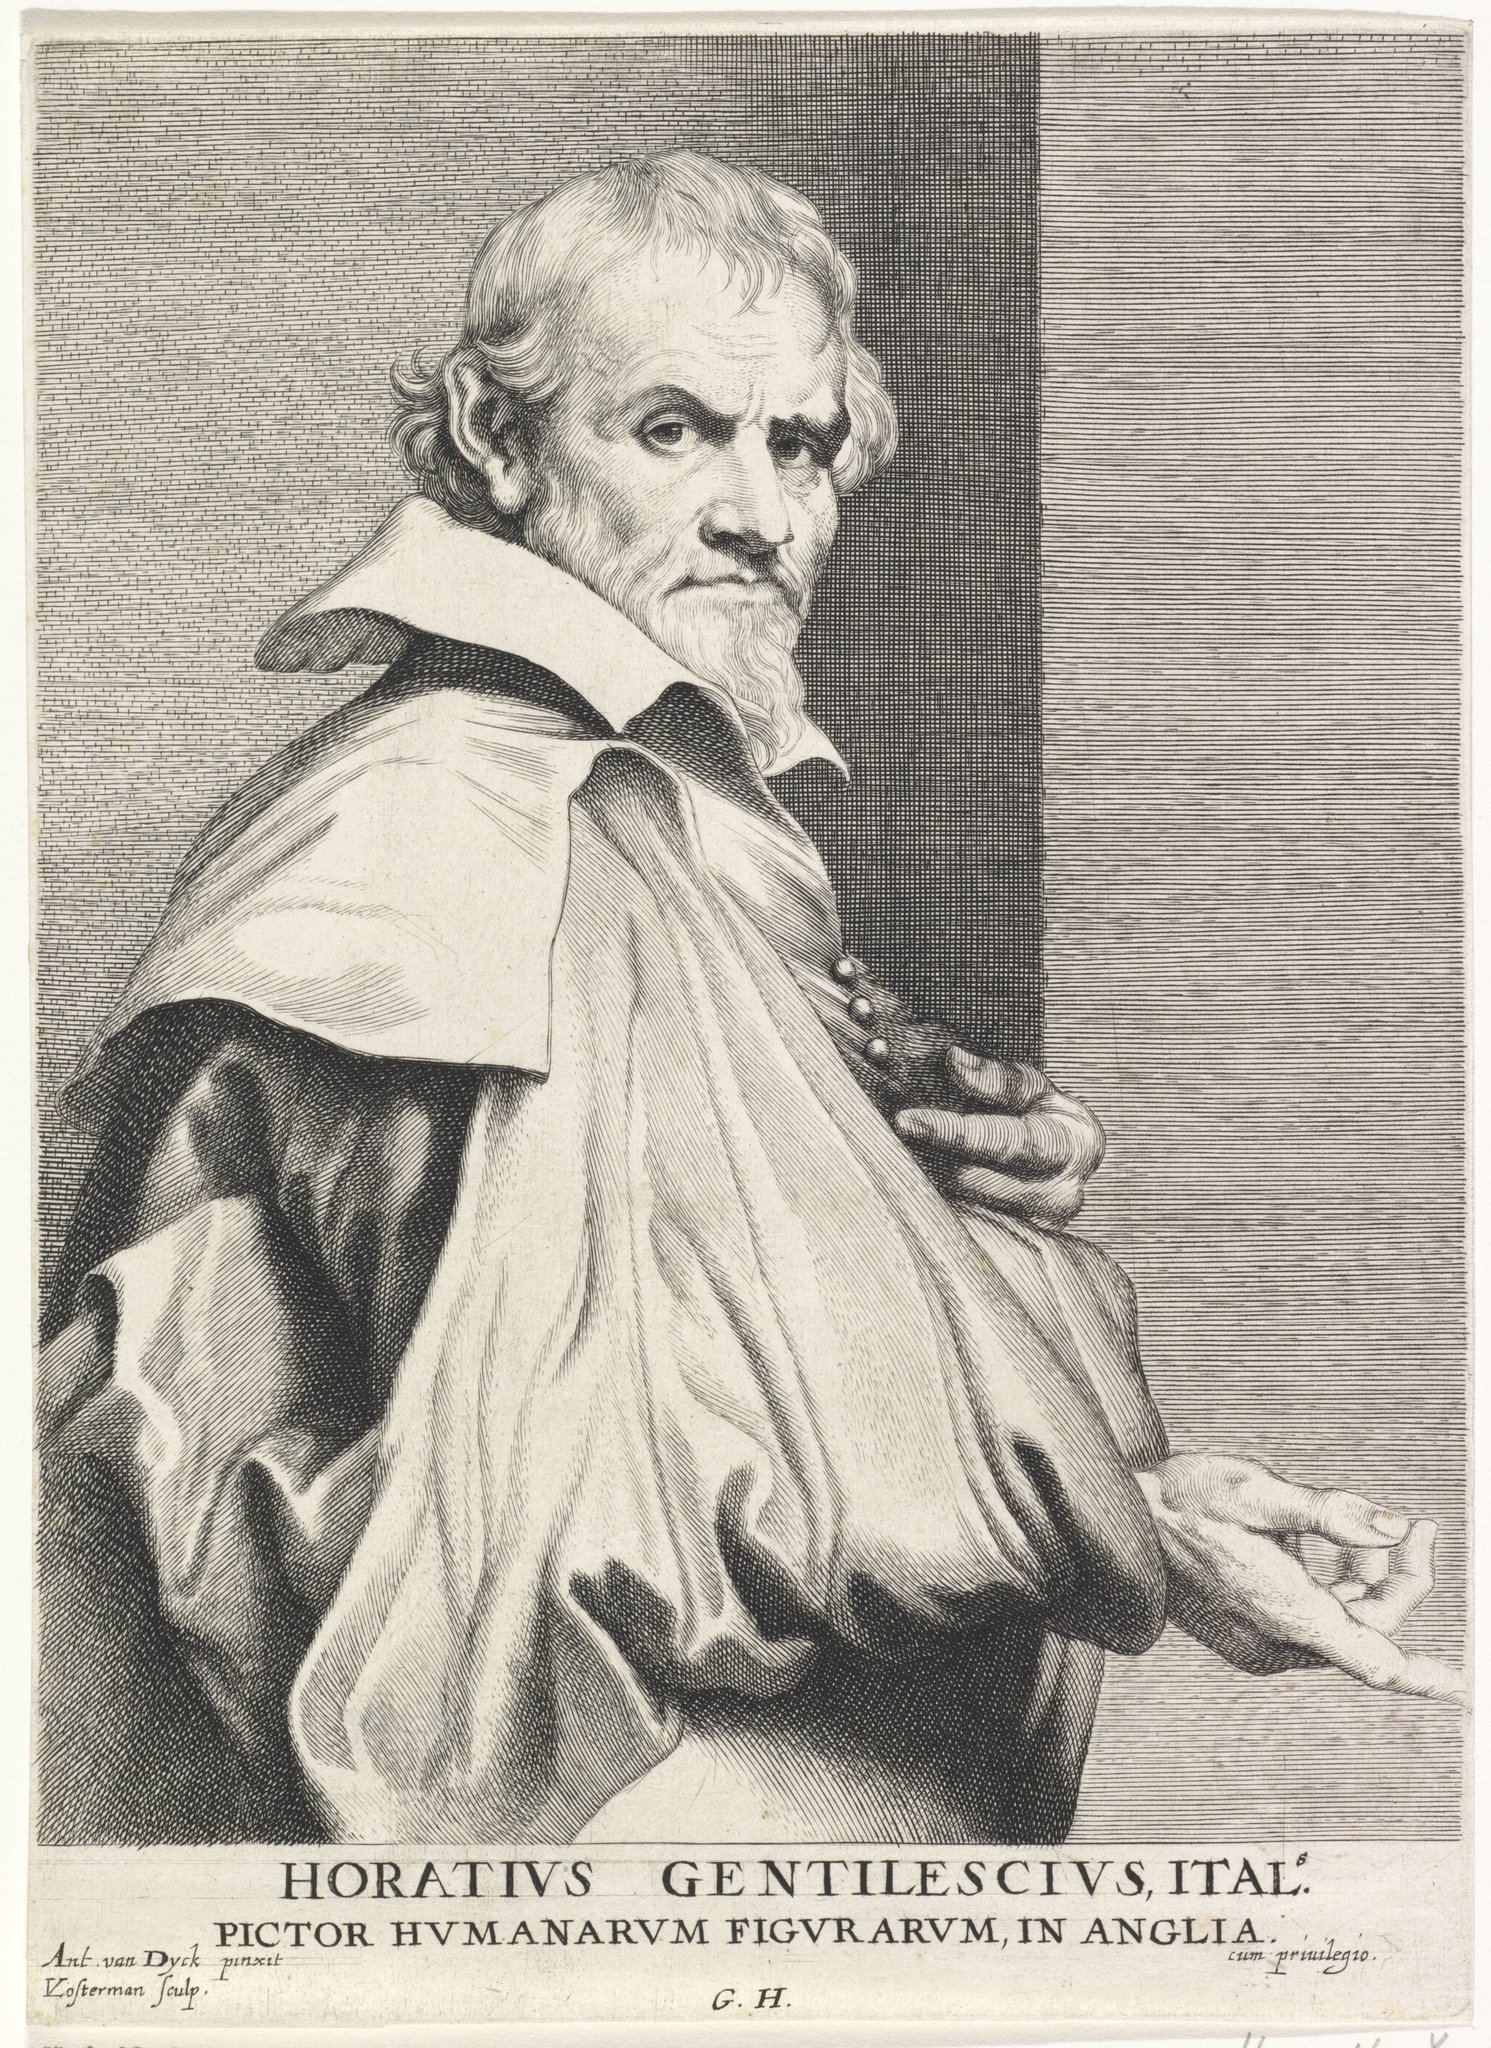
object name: print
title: Iconographie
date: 1645-1646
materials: paper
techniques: engraving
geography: antwerp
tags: london, painter, orazio gentileschi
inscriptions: collector's mark: Lugt 240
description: Prent gebruikt voor: Icones principum, virorum doctorum, pictorum, chalcographorum, statuariorum nec non amatorum pictoriae artis numero centum ab Ant. van Dyck ad vivum expressae ejusque sumptibus aeri incisae. Antwerpen: Gillis Hendricx, [1645-1646].